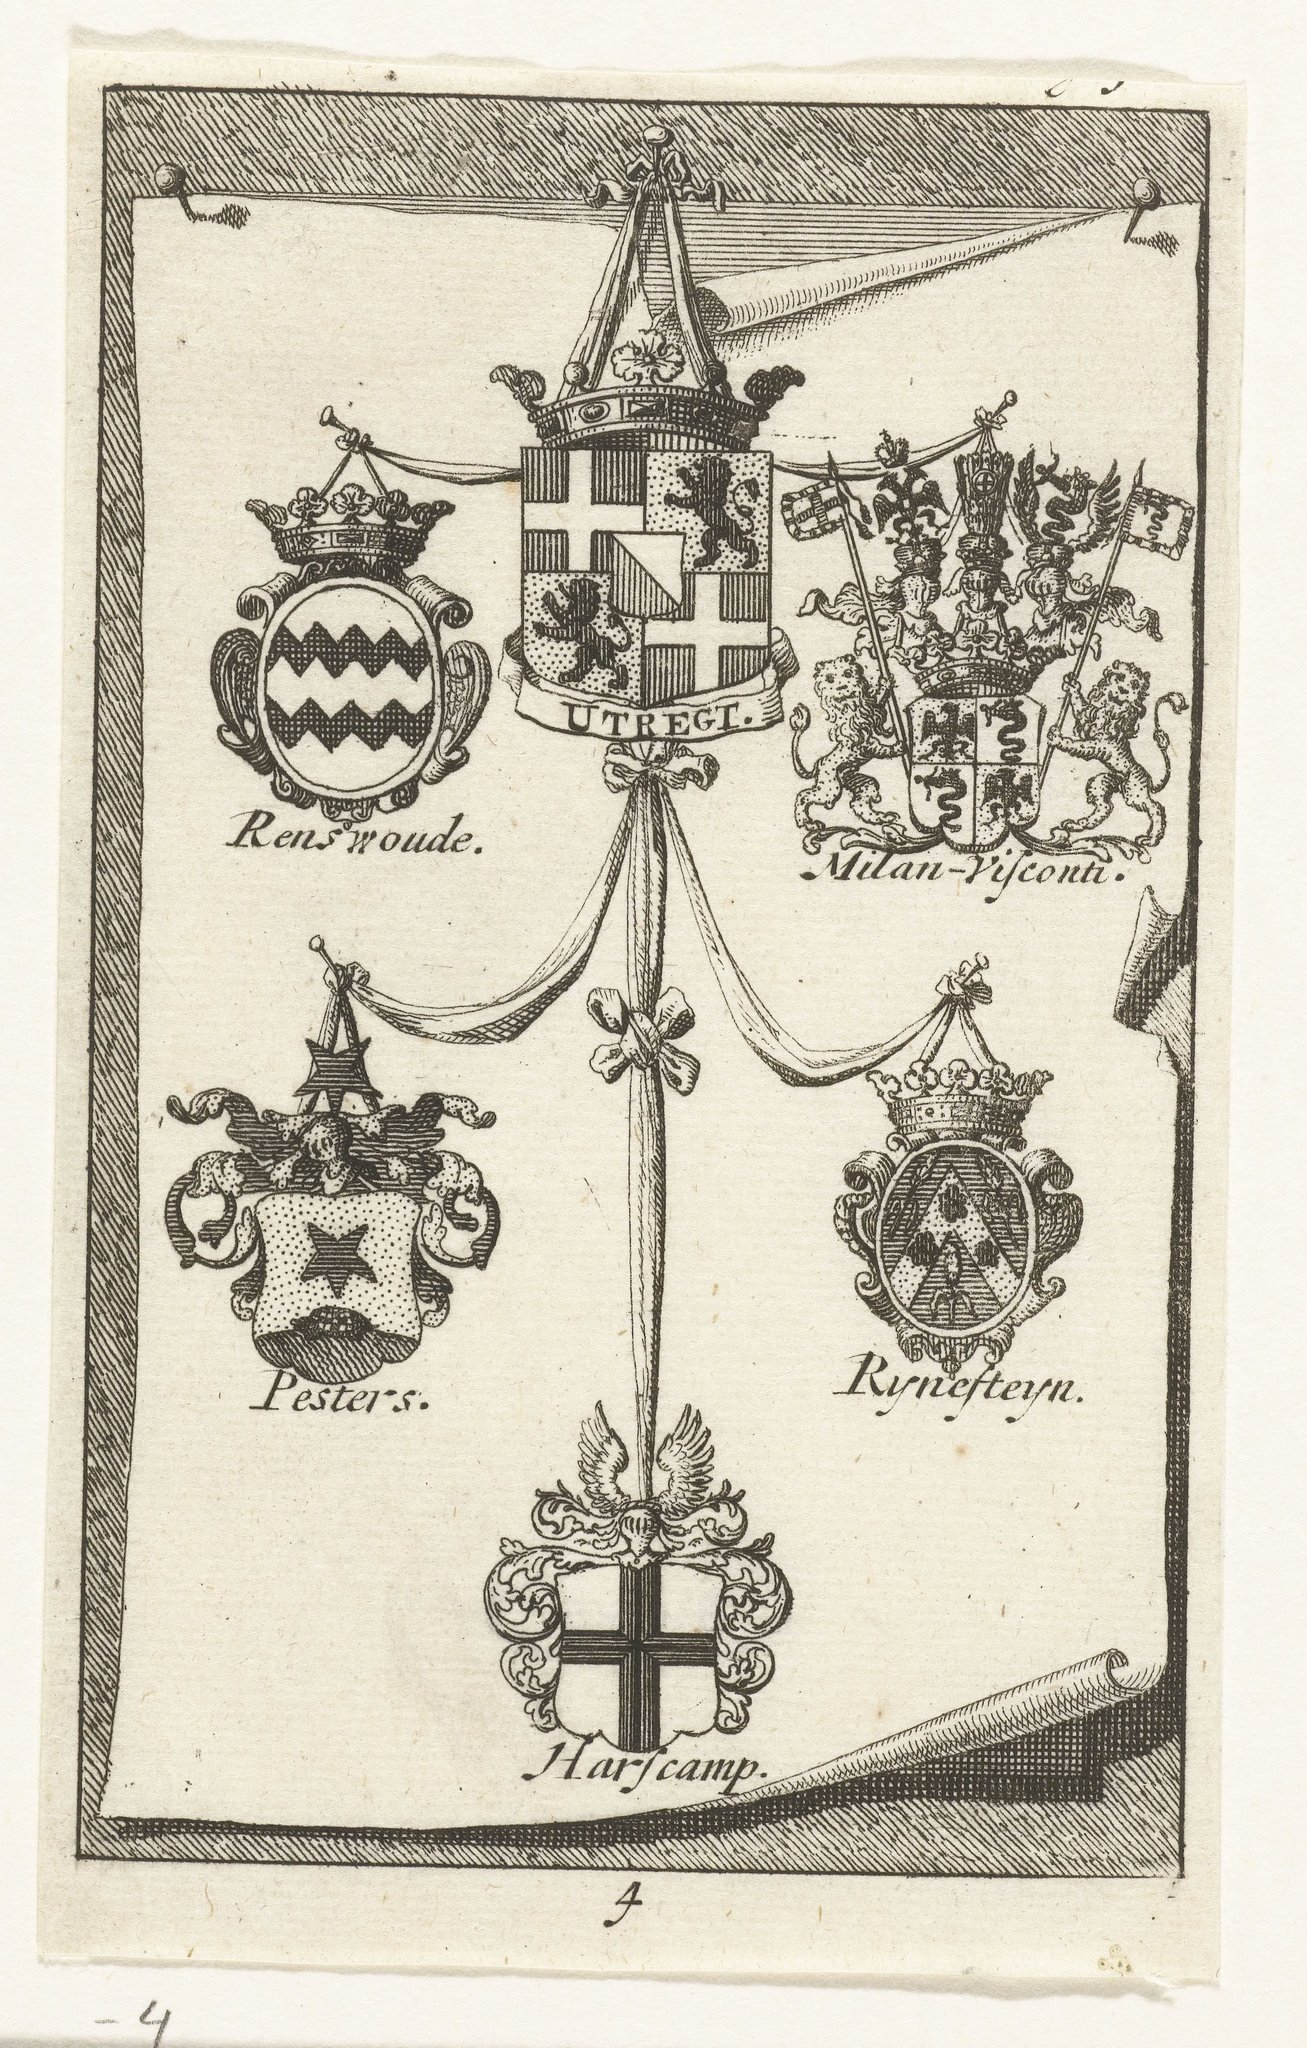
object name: print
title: Wapens van de gevolmachtigden van Utrecht bij de vredesonderhandelingen te Utrecht (nr. 4), 1712-1713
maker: Anonymous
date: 1713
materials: paper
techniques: etching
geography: northern netherlands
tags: weapons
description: Gebruikt als illustratie in: Nicolaas Chevalier, Lyste der namen ende qualiteiten van (...) de heeren plenipotentiarissen envoyees (...) op het congres, over de generale vrede, t'Utrecht, N. Chevalier, Utrecht 1713.